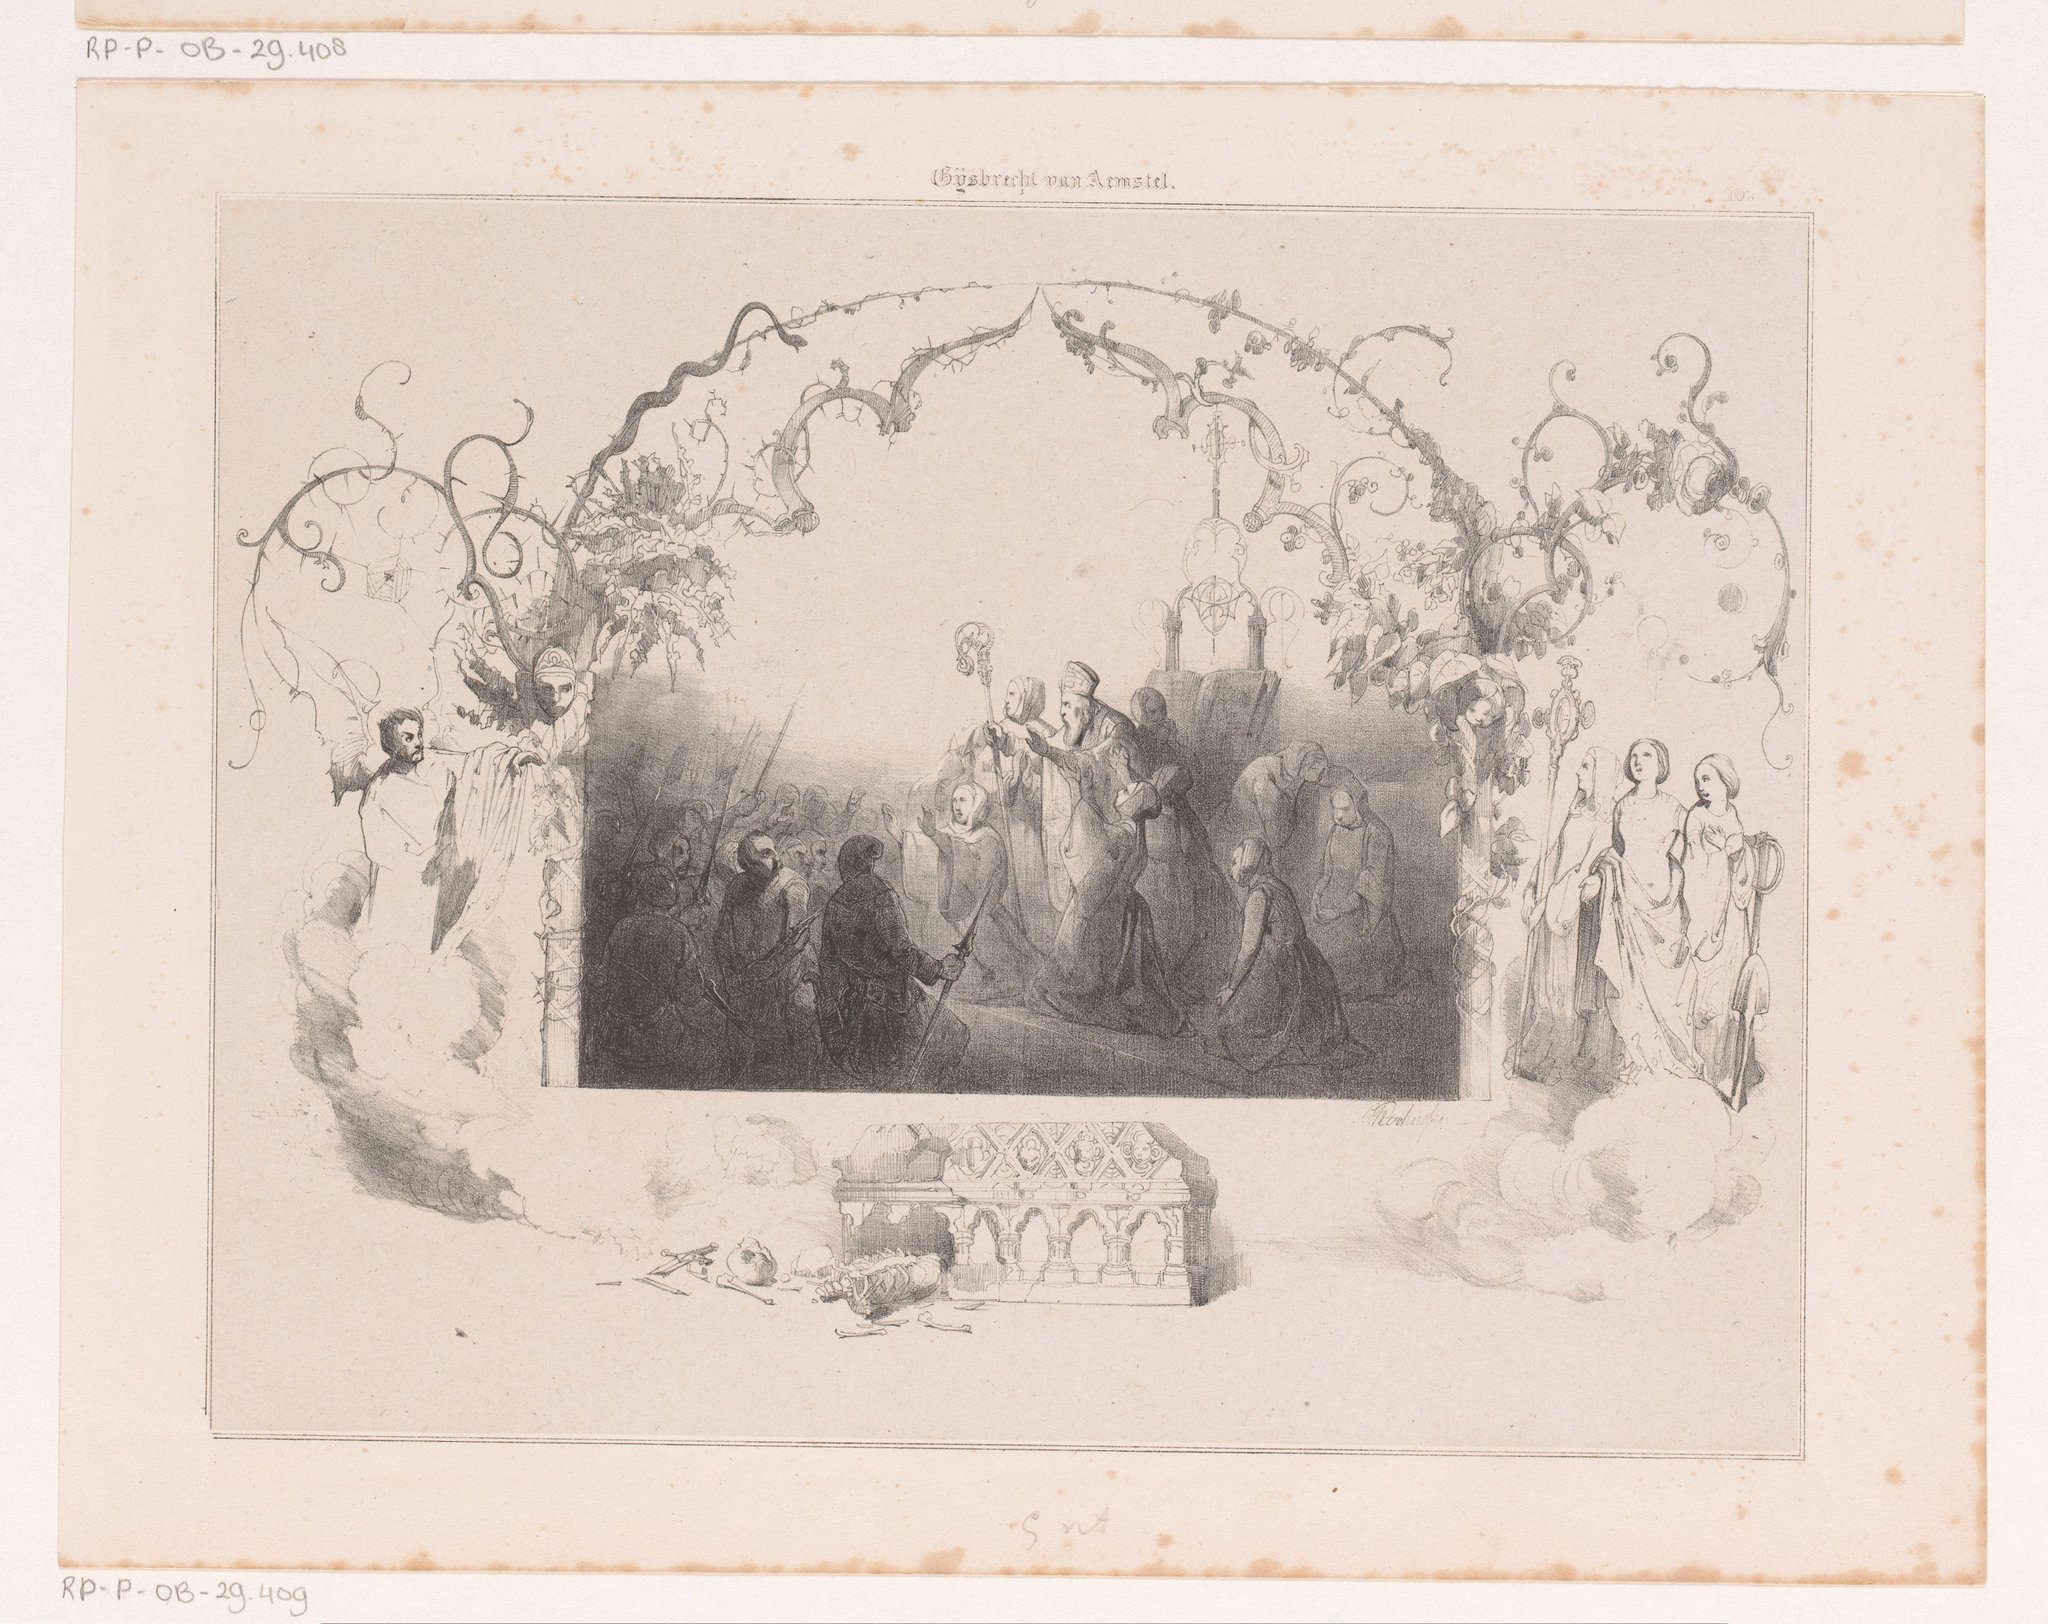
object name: book illustration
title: Bisschop en vrouwen voor groep ridders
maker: charles rochussen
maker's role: draughtsman, painter, print maker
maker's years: 1814-1894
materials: paper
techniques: lithograph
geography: the hague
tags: archbishop, bishop, etc. (roman catholic), knight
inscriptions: collector's mark: Lugt 2228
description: Een bisschop staat met staf en geheven handen voor een groep ridders. Rondom hem zitten geknielde vrouwen. Rondom diverse scènes met een duivels figuur, drie vrouwen (mogelijk de drie theologische deugden) en een geplunderde sarcofaag.